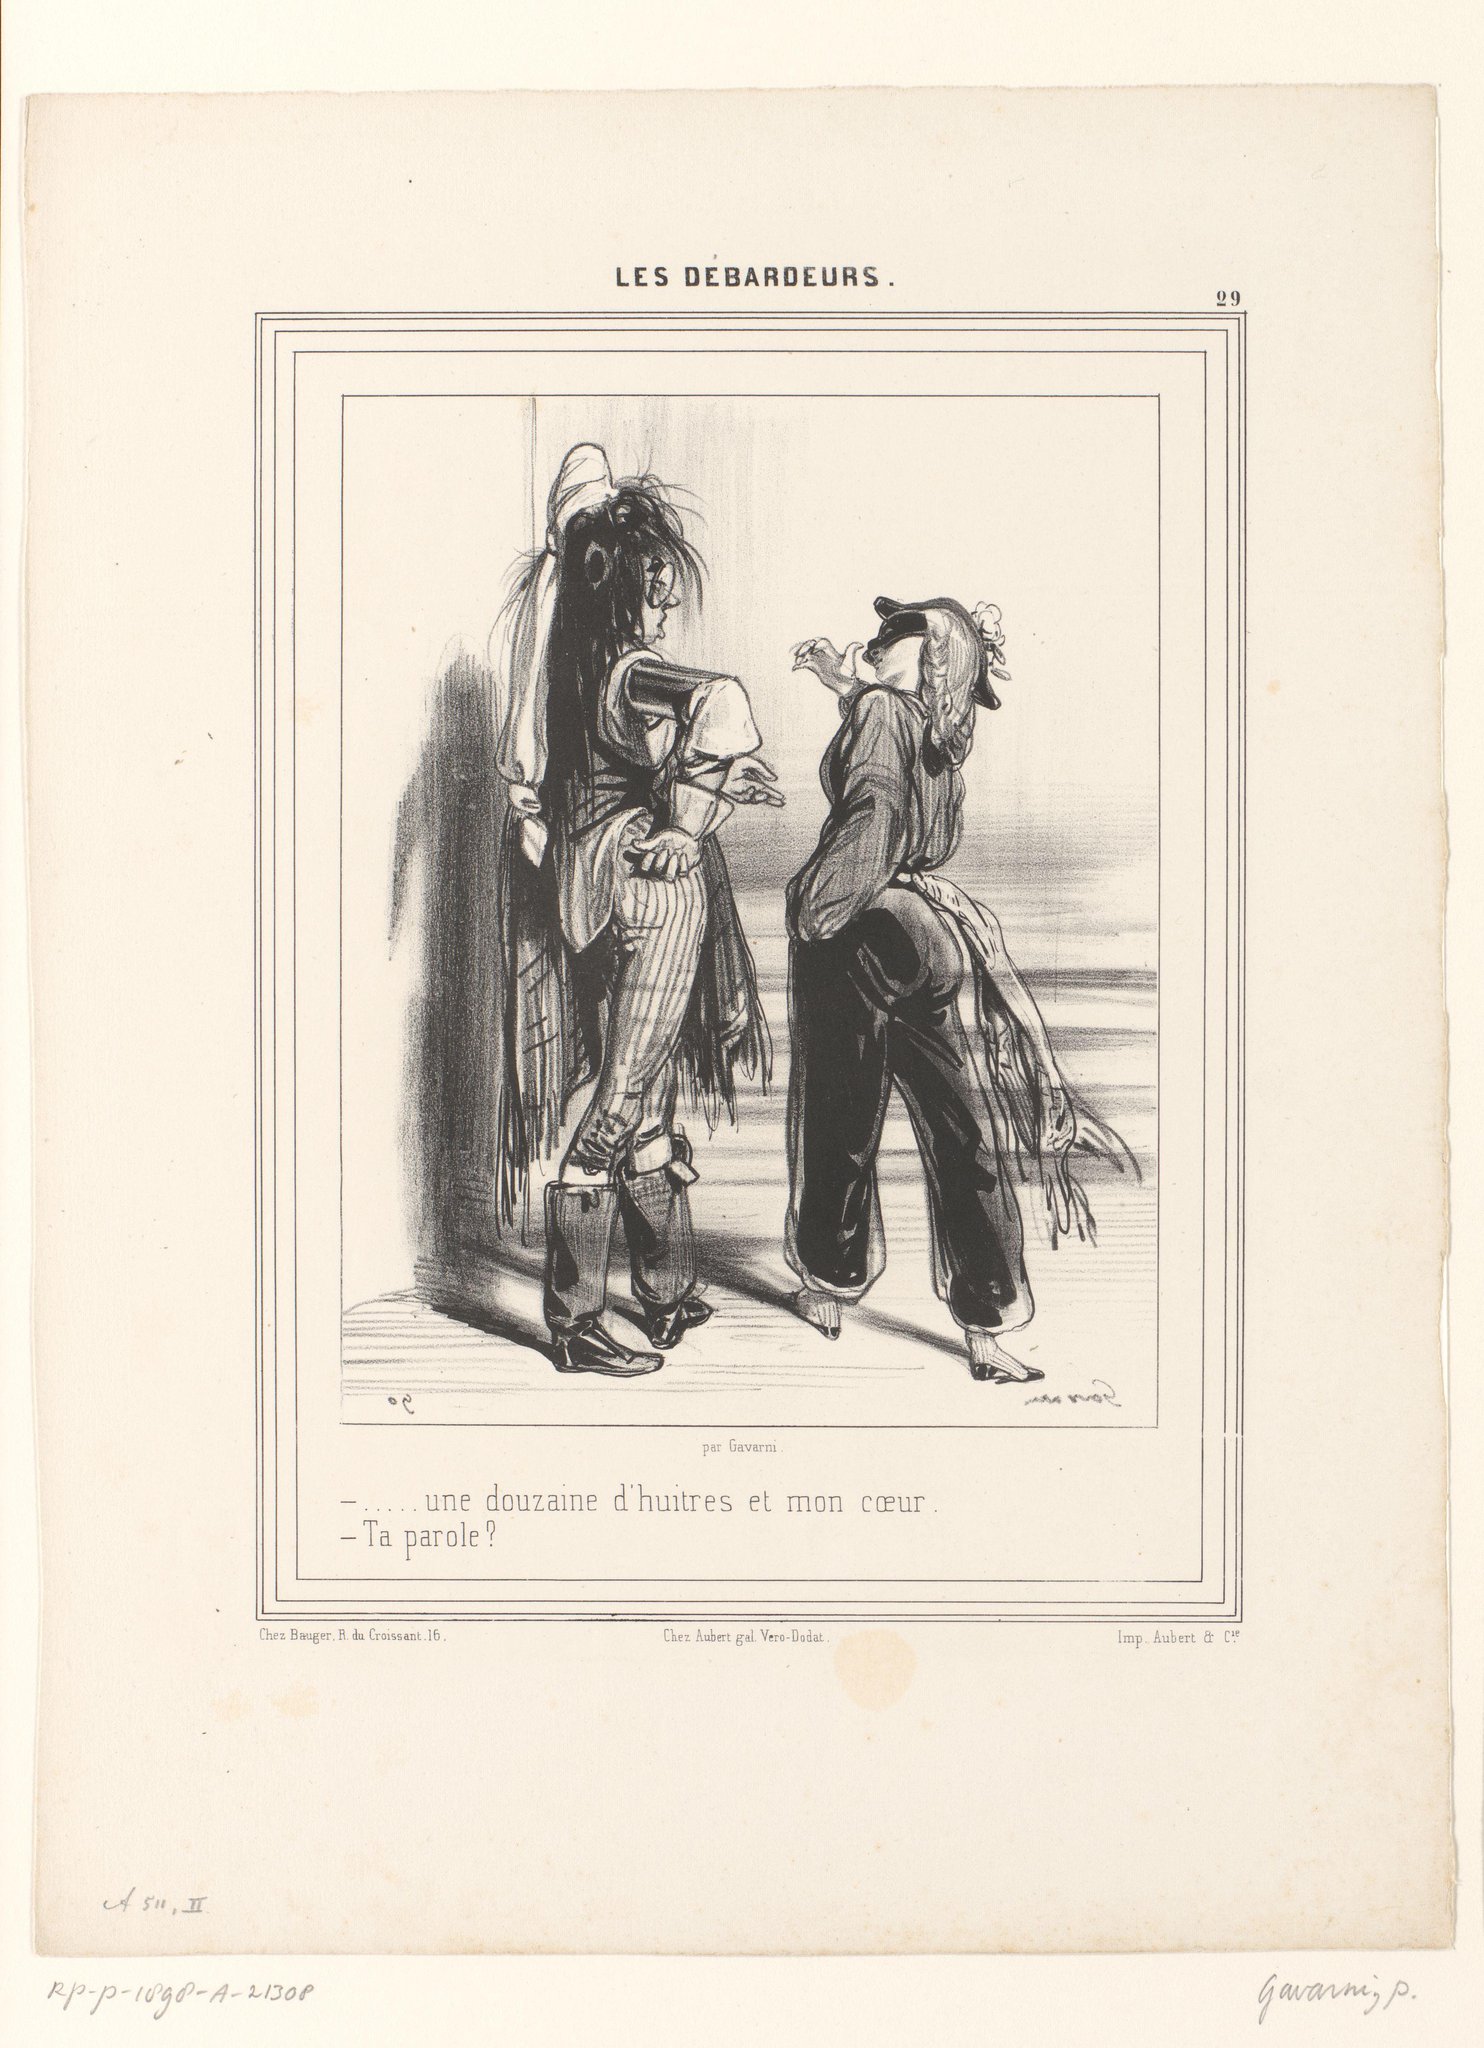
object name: cartoon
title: Jonge vrouw flirt met een jongeman op straat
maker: paul gavarni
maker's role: draughtsman, print maker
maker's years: 1804-1866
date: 1841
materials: paper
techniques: lithograph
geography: paris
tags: fashion, clothing, courting, street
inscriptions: collector's mark: Lugt 964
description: Prent gebruikt voor: Le Charivari, 6 januari 1841.